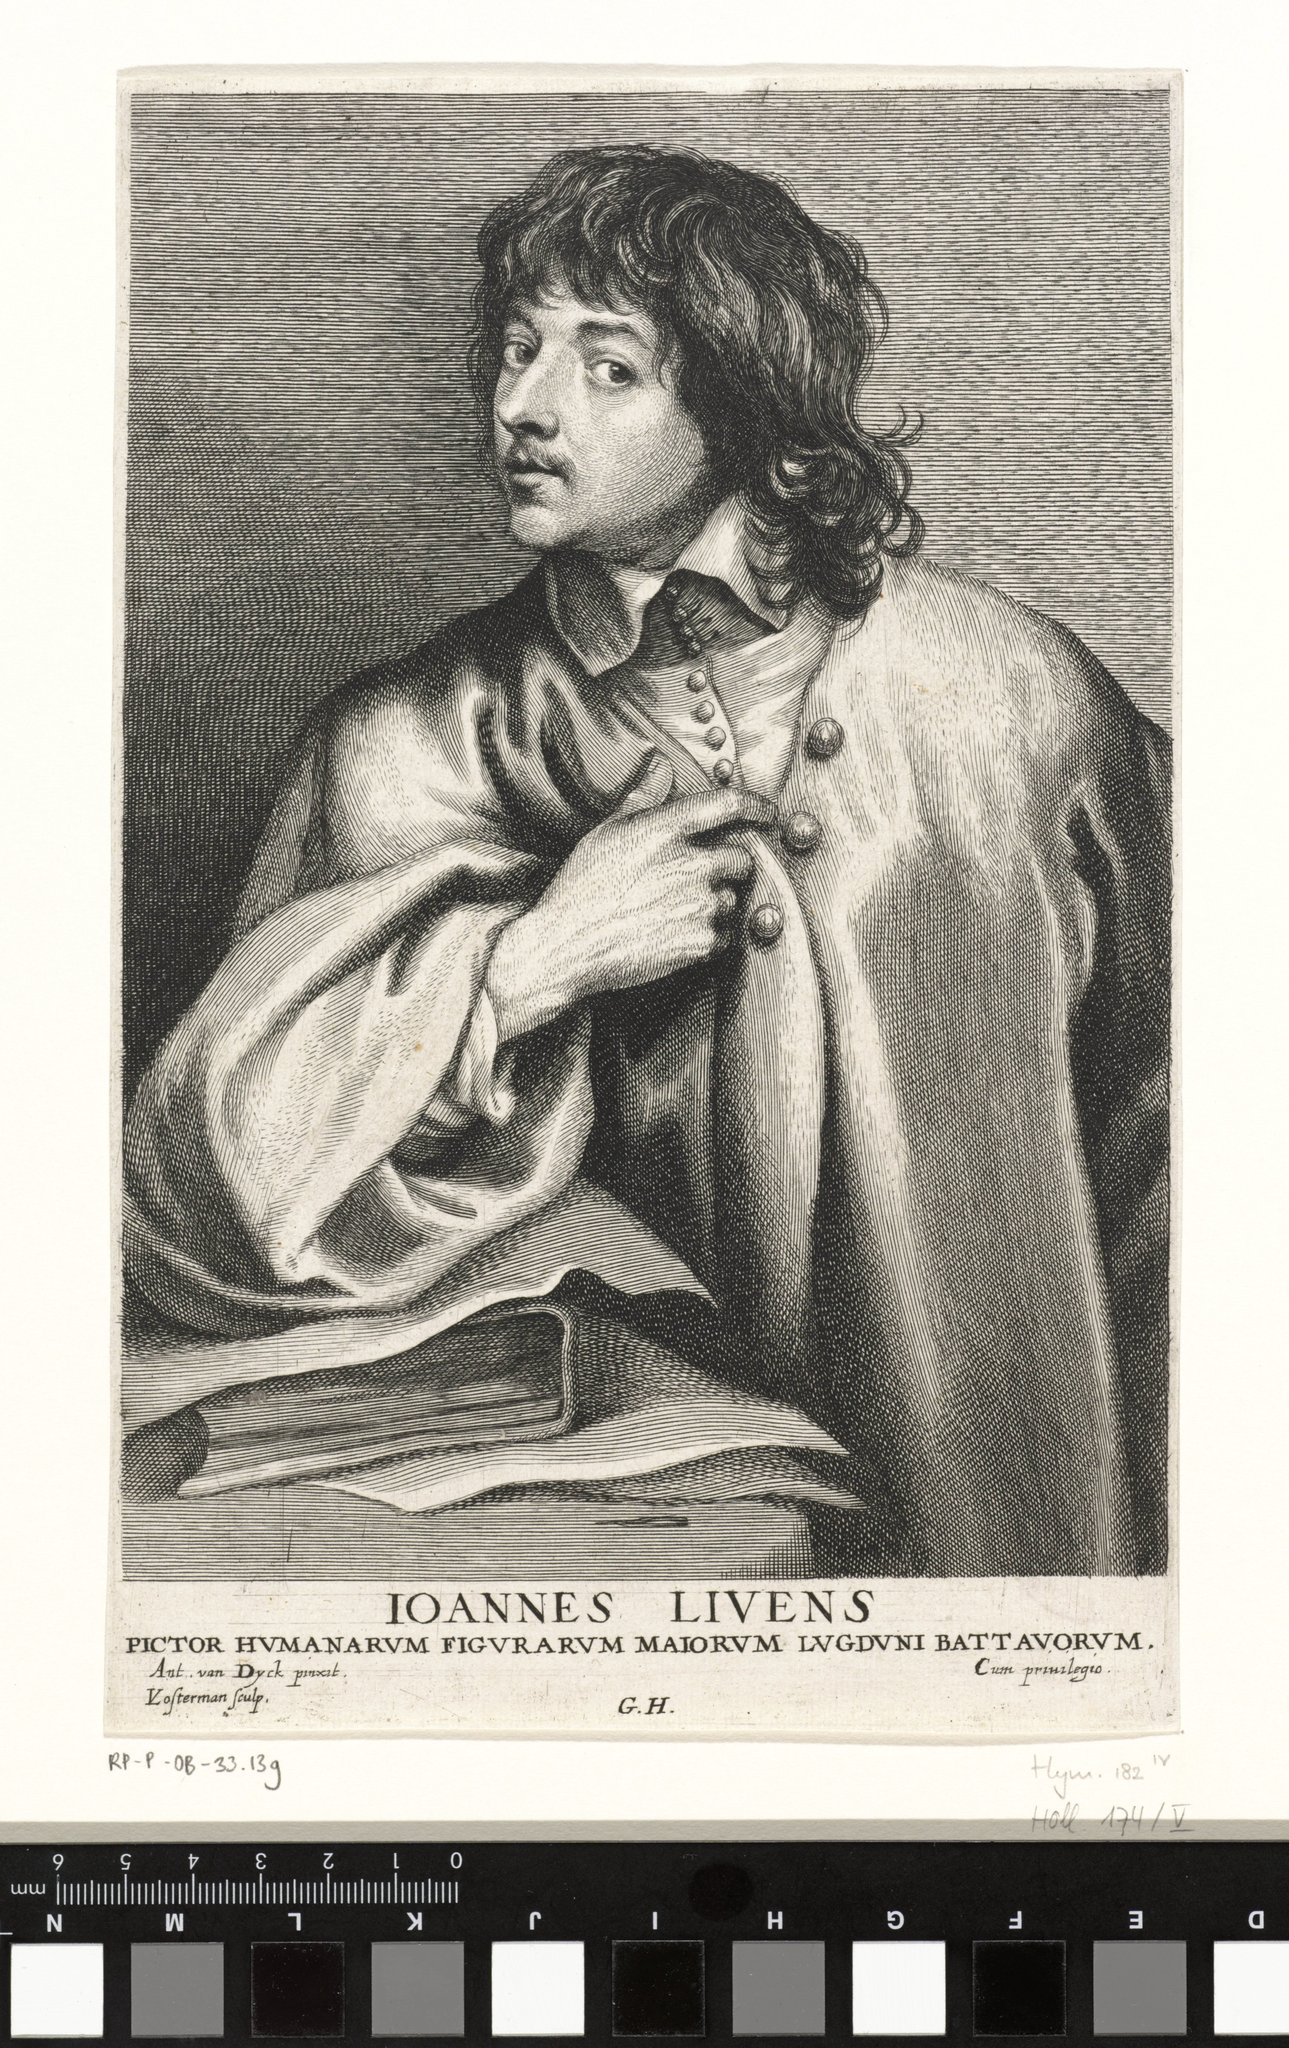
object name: print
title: Portret van Jan Lievens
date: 1645-1646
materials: paper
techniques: engraving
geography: antwerp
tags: leiden, amsterdam, painter, print maker, draughtsman, jan lievens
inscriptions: collector's mark: Lugt 240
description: Prent gebruikt voor: Icones principum, virorum doctorum, pictorum, chalcographorum, statuariorum nec non amatorum pictoriae artis numero centum ab Ant. van Dyck ad vivum expressae ejusque sumptibus aeri incisae. Antwerpen: Gillis Hendricx, [1645-1646].